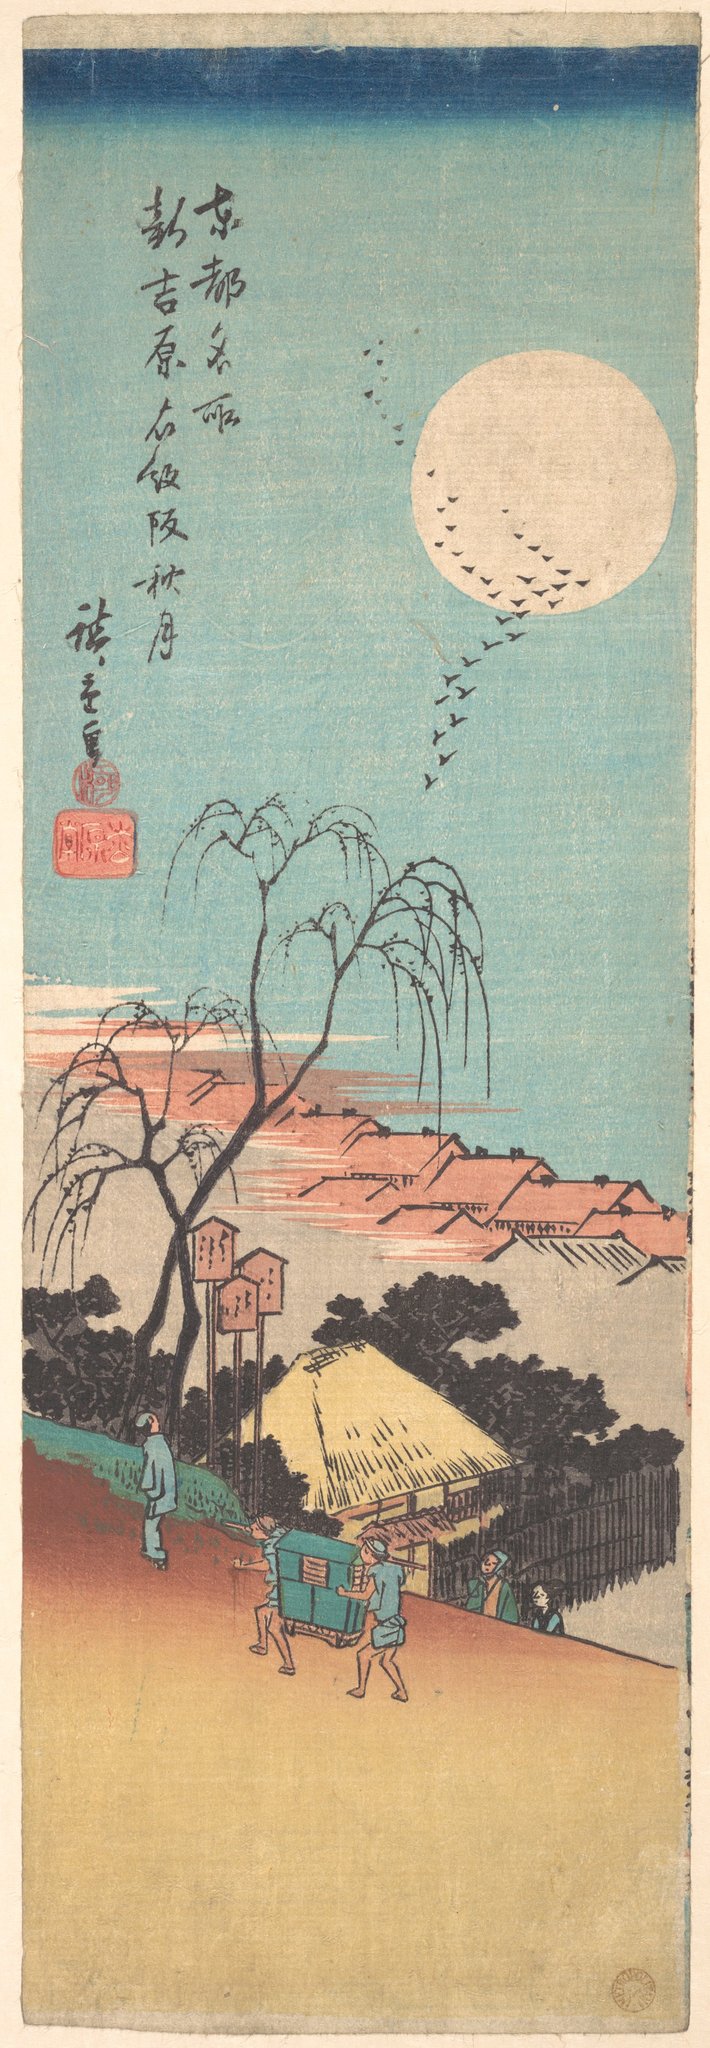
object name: print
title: Shin Yoshiwara Emonzaka Aki no Tsuki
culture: japanese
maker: utagawa hiroshige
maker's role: artist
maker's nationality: japanese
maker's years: 1797-1858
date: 1836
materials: ink, paper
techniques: woodblock print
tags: human figures,birds,houses,moon,trees